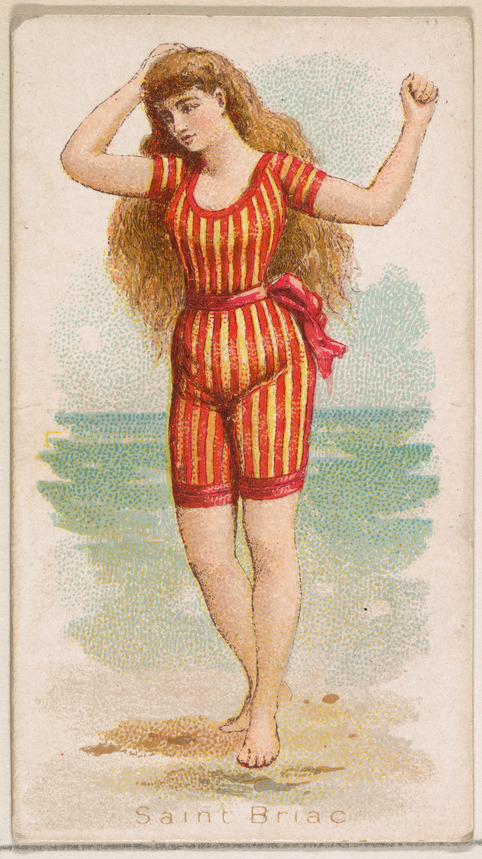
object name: print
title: Saint Briac, from the Fancy Bathers series (N187) issued by Wm. S. Kimball & Co.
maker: william s. kimball & company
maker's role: publisher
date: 1889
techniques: color lithograph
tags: women